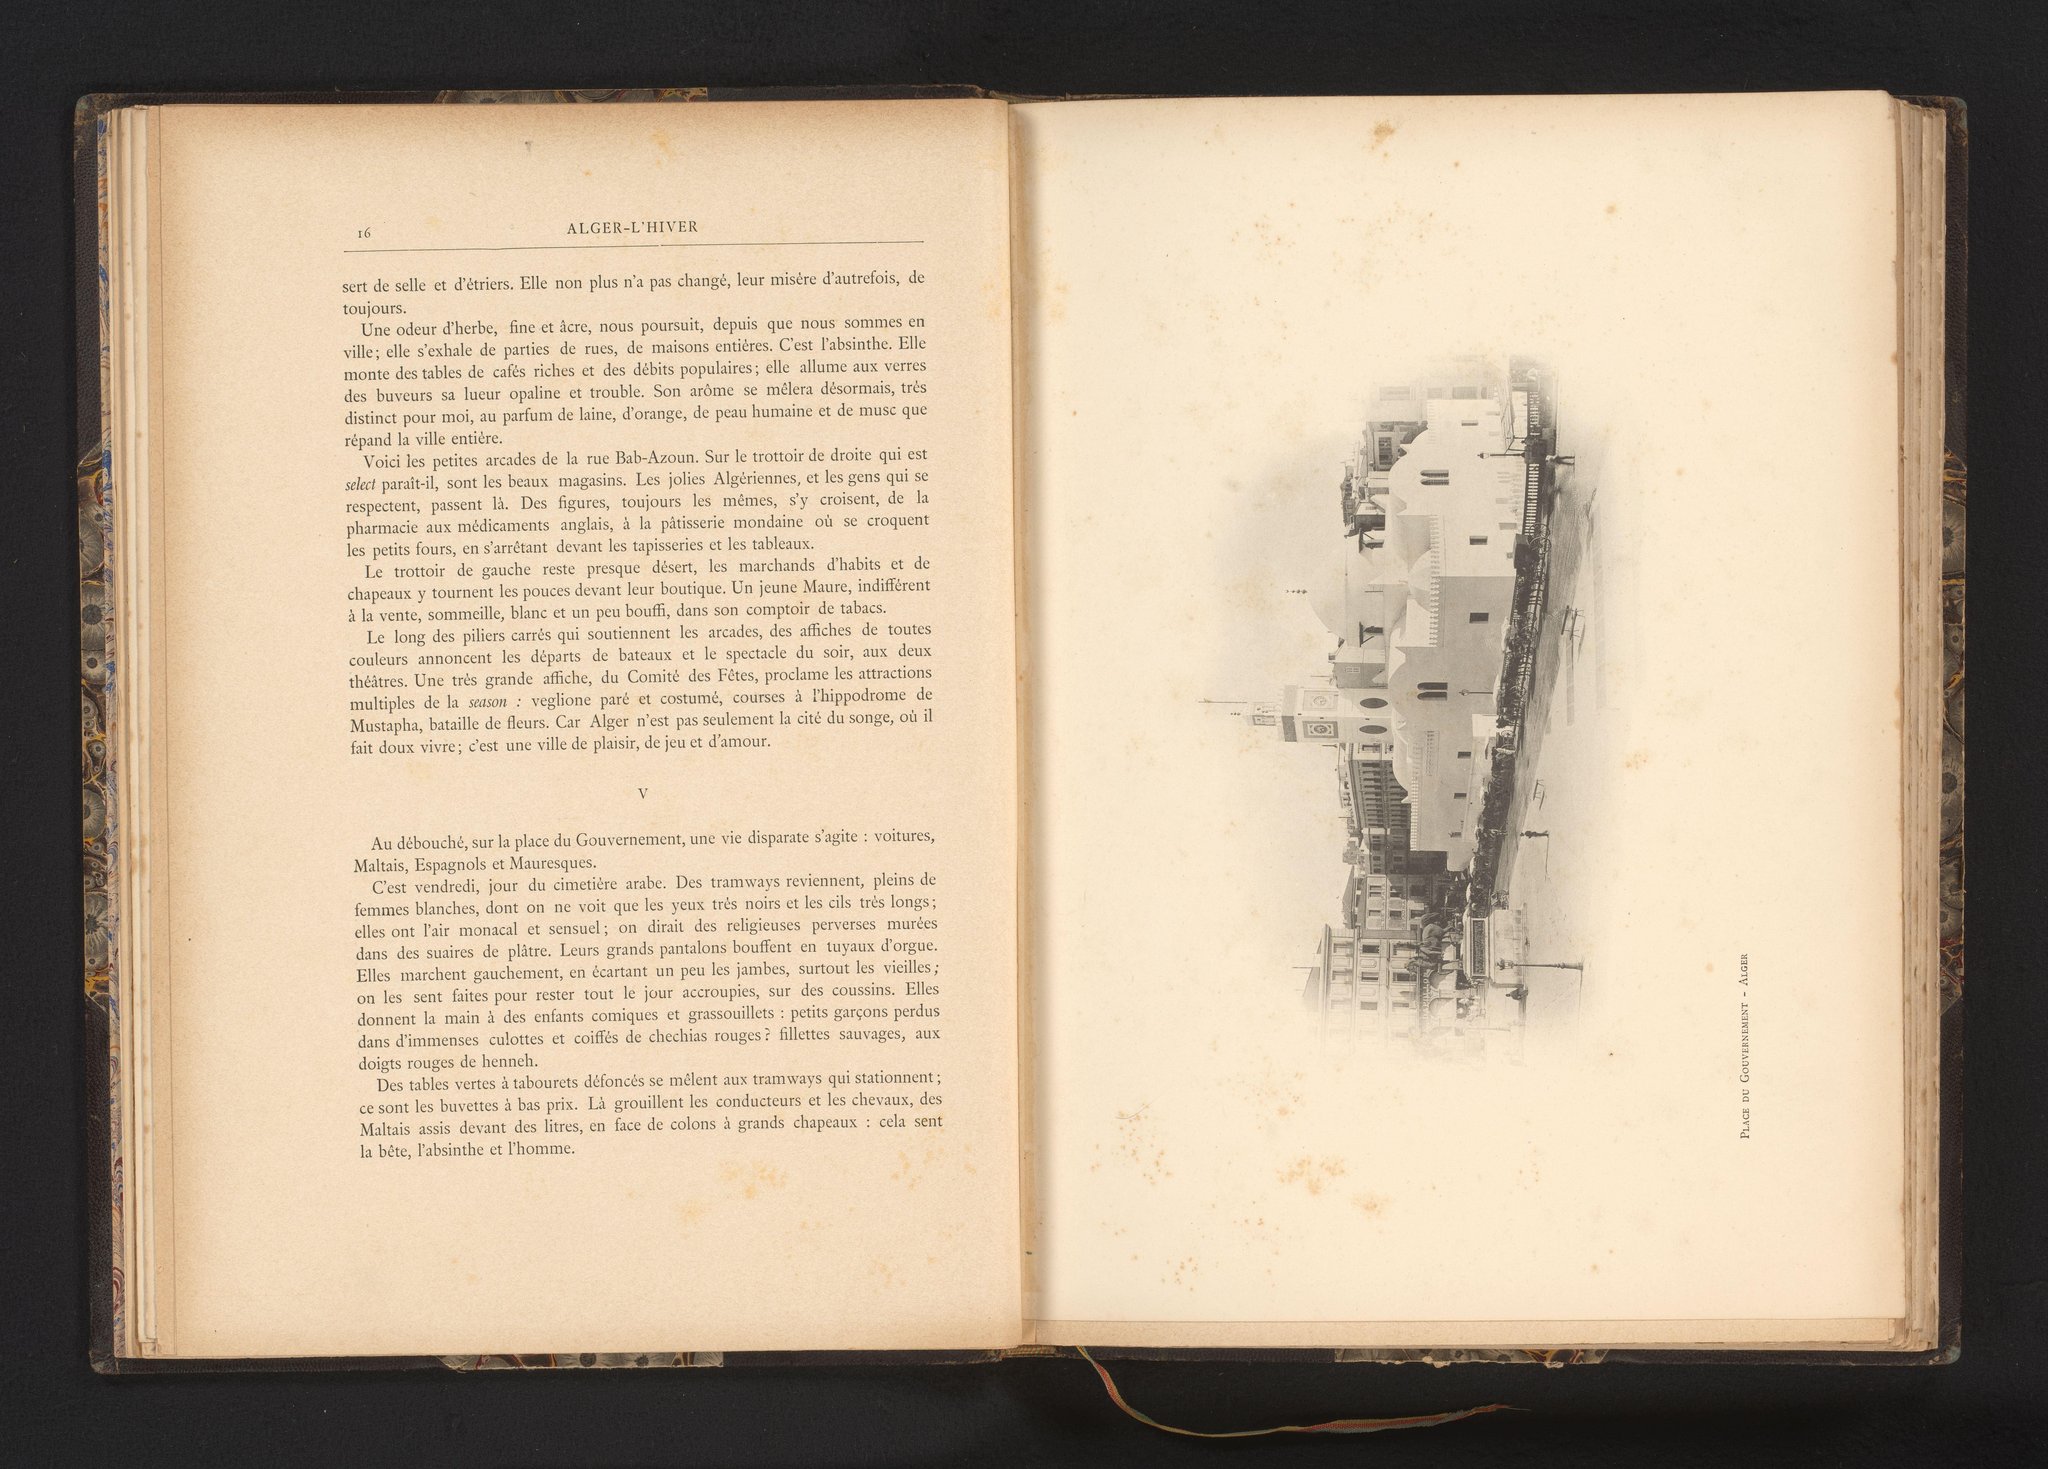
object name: photomechanical print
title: Gezicht op de Place de Gouvernement in Algiers, Algerije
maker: jules gervais-courtellemont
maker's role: fotograaf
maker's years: 1863-1931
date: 1888-1893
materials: paper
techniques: photograph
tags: square, place, circus, etc., temple, shrine ~ islam, mohammedanism